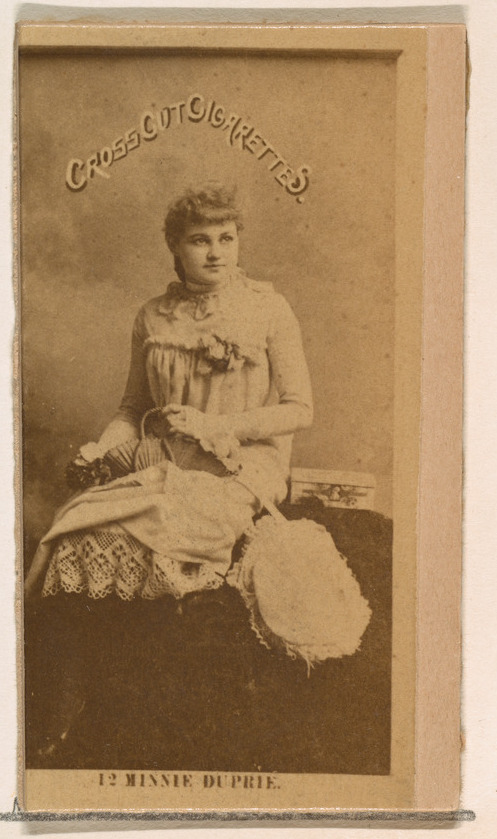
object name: print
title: Card Number 42, Minnie Dupree, from the Actors and Actresses series (N145-2) issued by Duke Sons & Co. to promote Cross Cut Cigarettes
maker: w. duke, sons & co.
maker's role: publisher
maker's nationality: american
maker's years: 1870-1920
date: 1880-1889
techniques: albumen silver print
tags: portraits,women,actresses